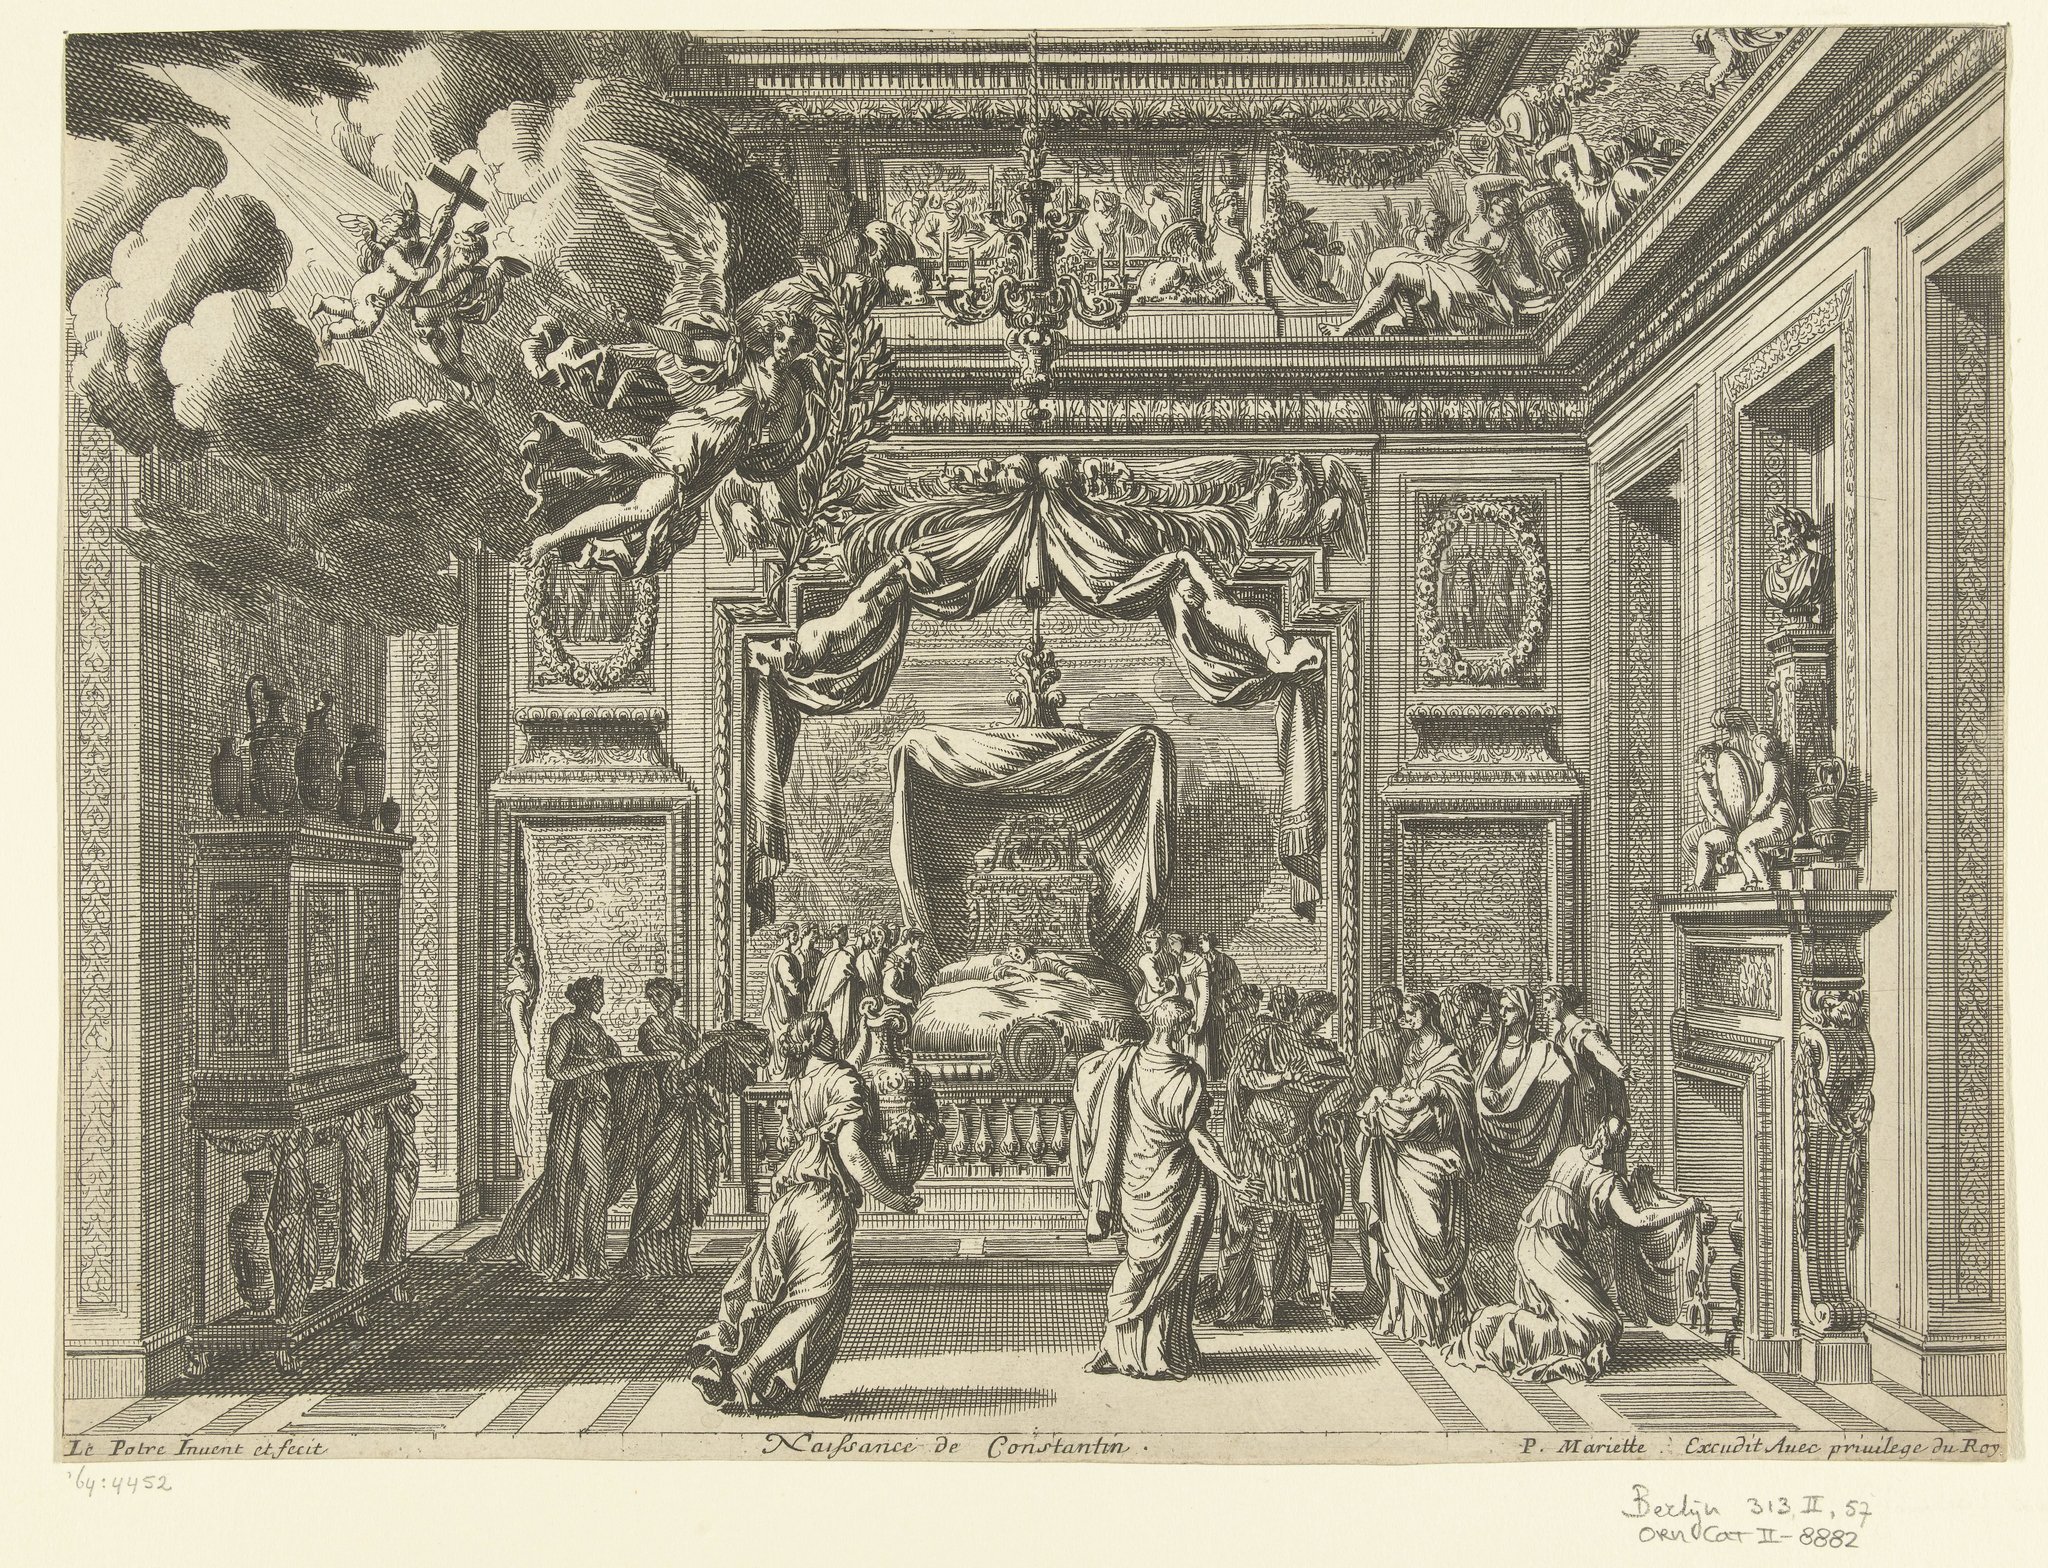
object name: ornament print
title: Naissance de Constantin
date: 1667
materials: paper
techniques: etching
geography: paris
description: Interieur met alkoof. In het midden staat een hemelbed, rechts vooraan staat een vroedvrouw die de pasgeboren Constantijn toont. Blad 4 uit serie van 6 bladen, tweede editie.